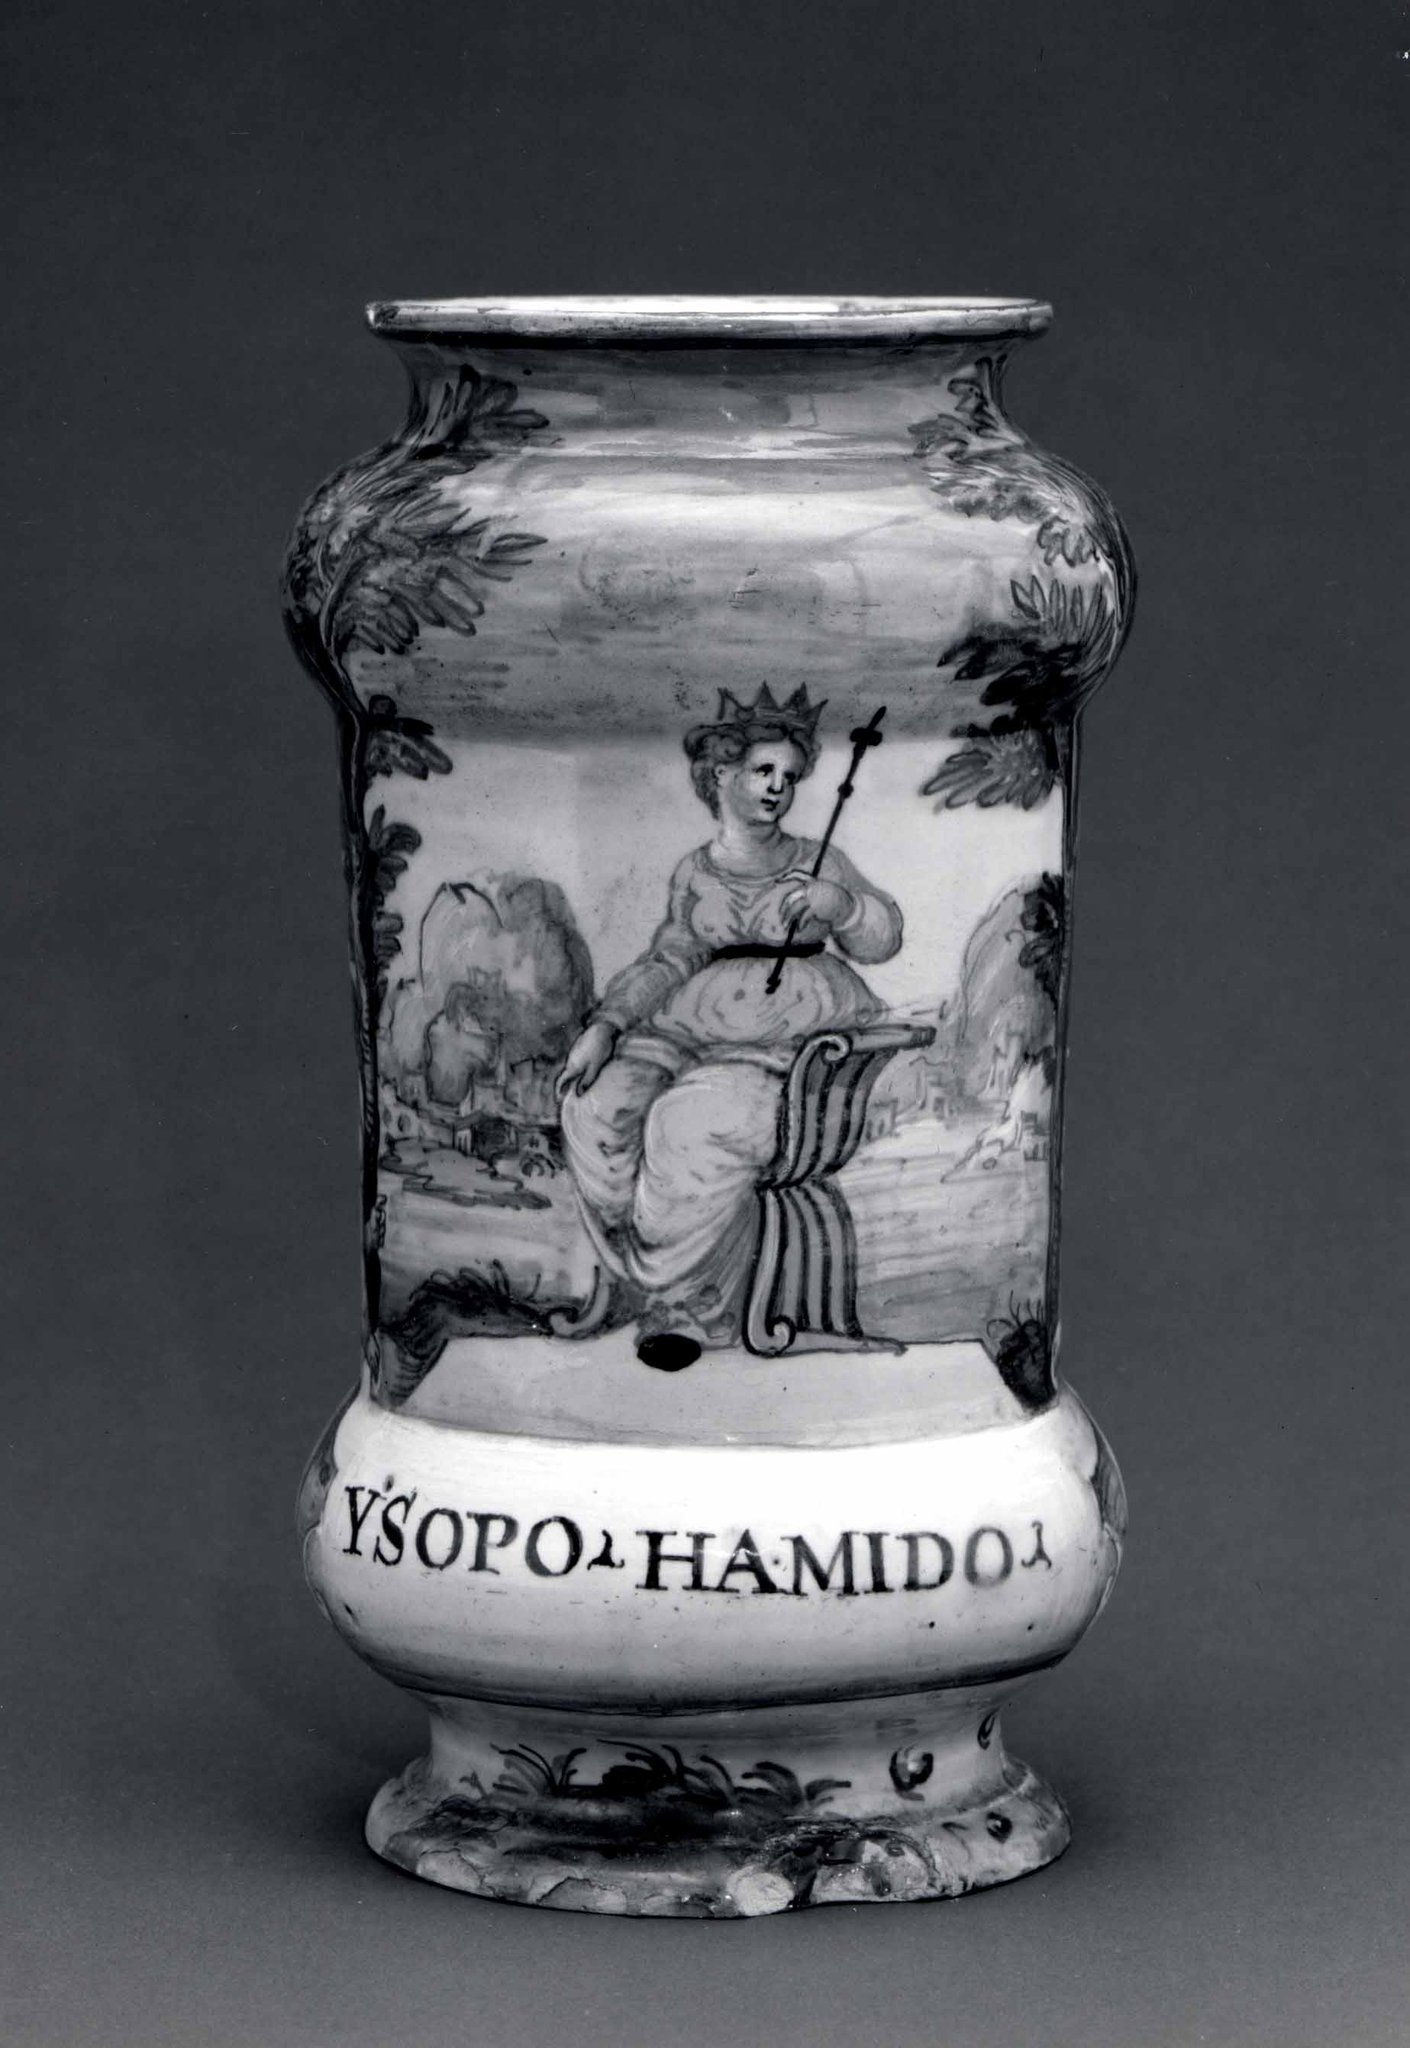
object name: albarello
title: Apothecary jar (albarello)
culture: italian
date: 1560-1570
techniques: maiolica, glazing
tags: women